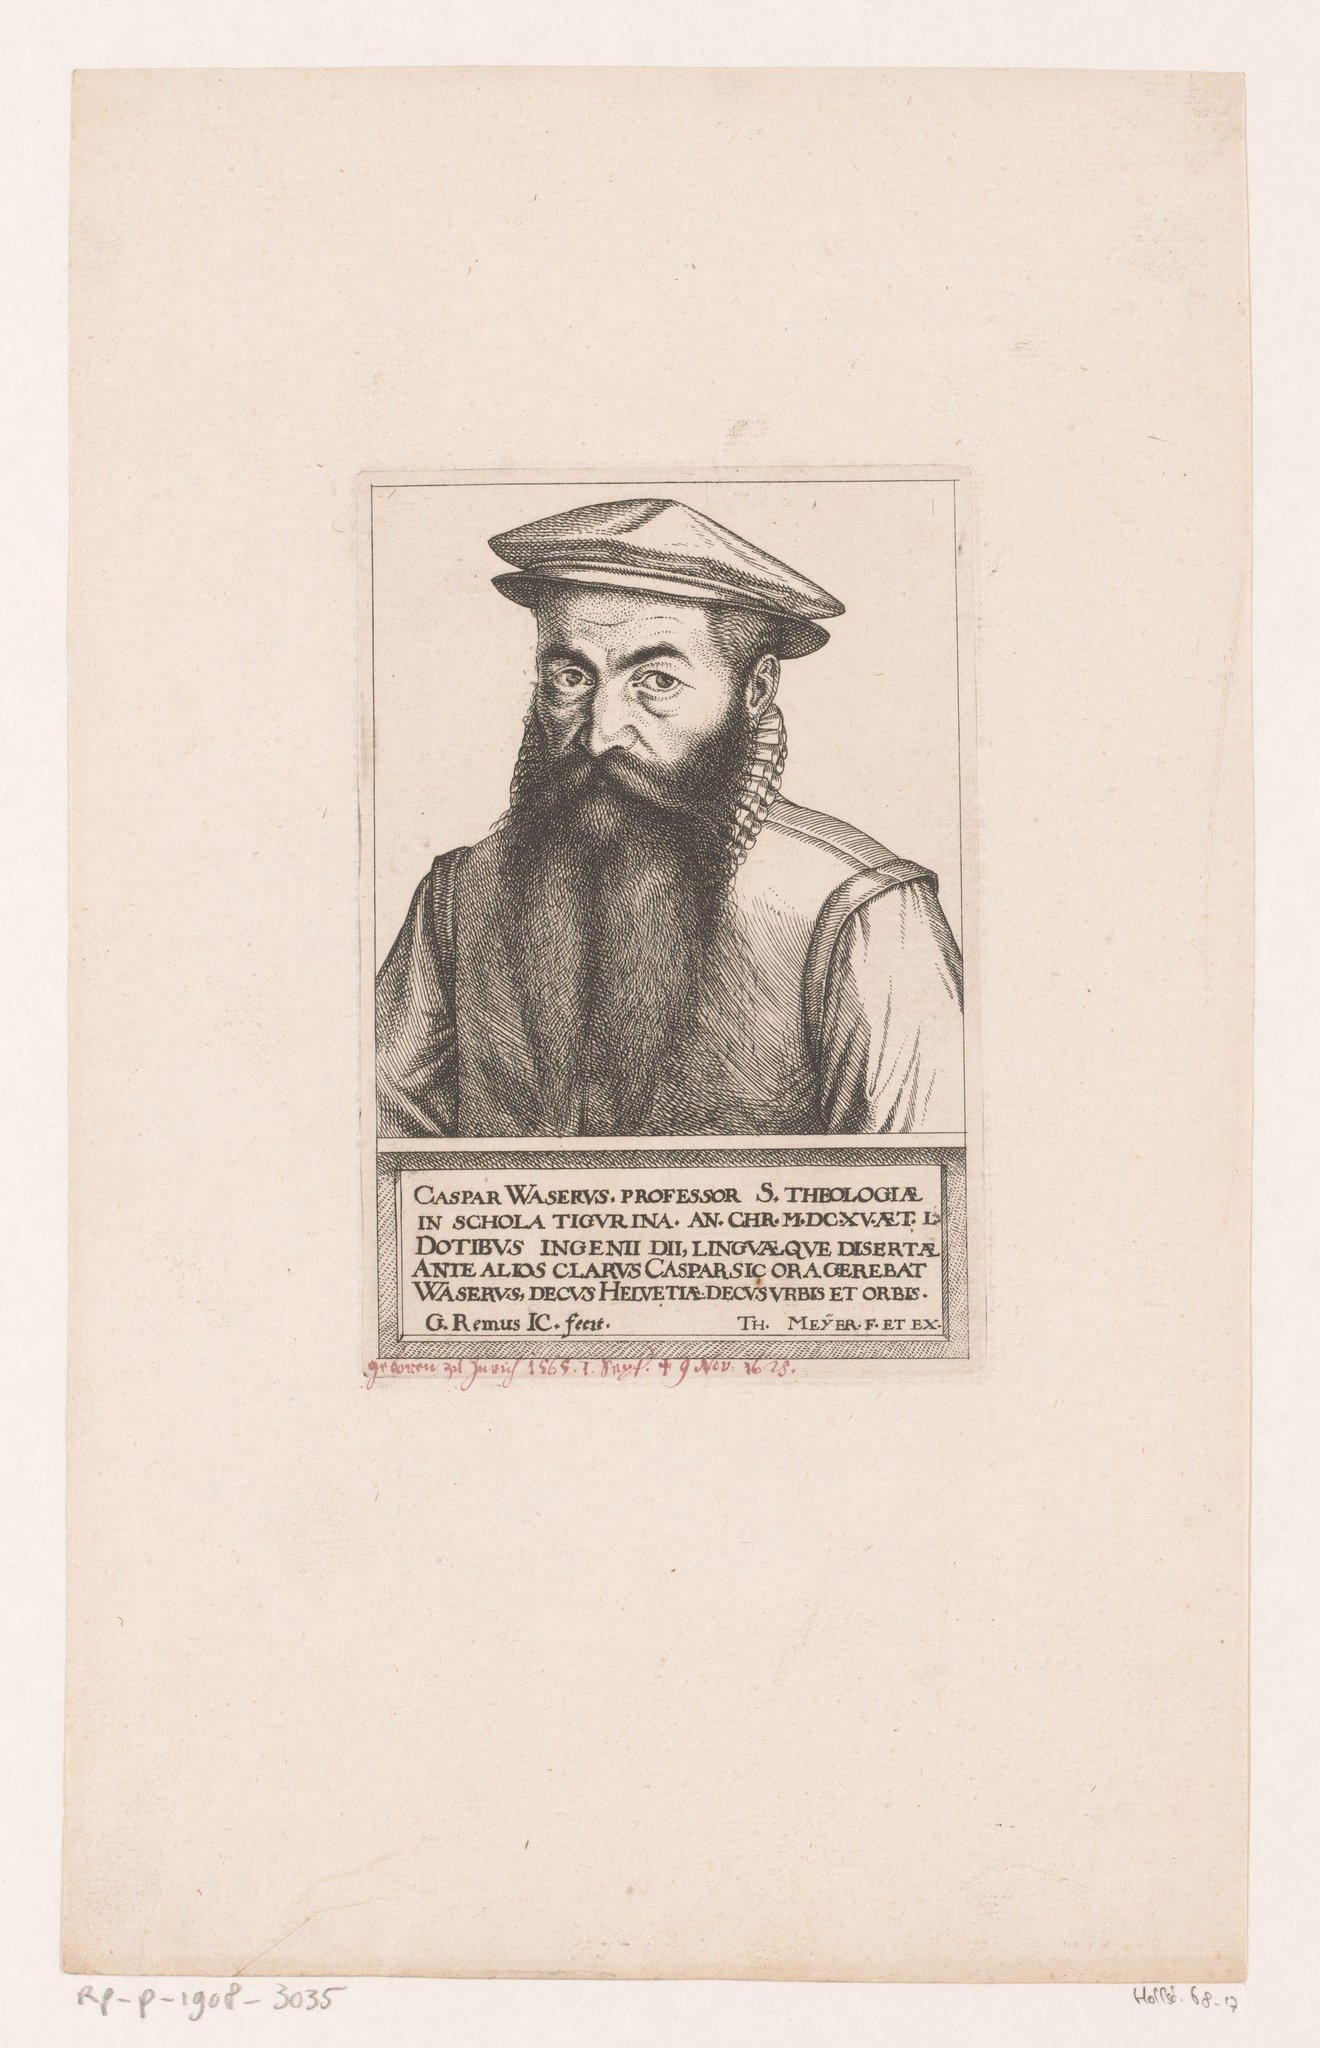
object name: print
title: Portretten van priesters en theologen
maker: dietrich meyer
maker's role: painter, print maker, publisher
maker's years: 1572-1658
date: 1582-1658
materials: paper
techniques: engraving, etching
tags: theologian, historical persons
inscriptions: collector's mark: Lugt 2228